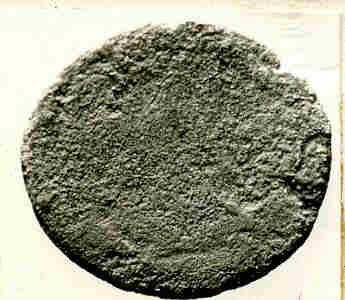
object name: coin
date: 758-768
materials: copper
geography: iran